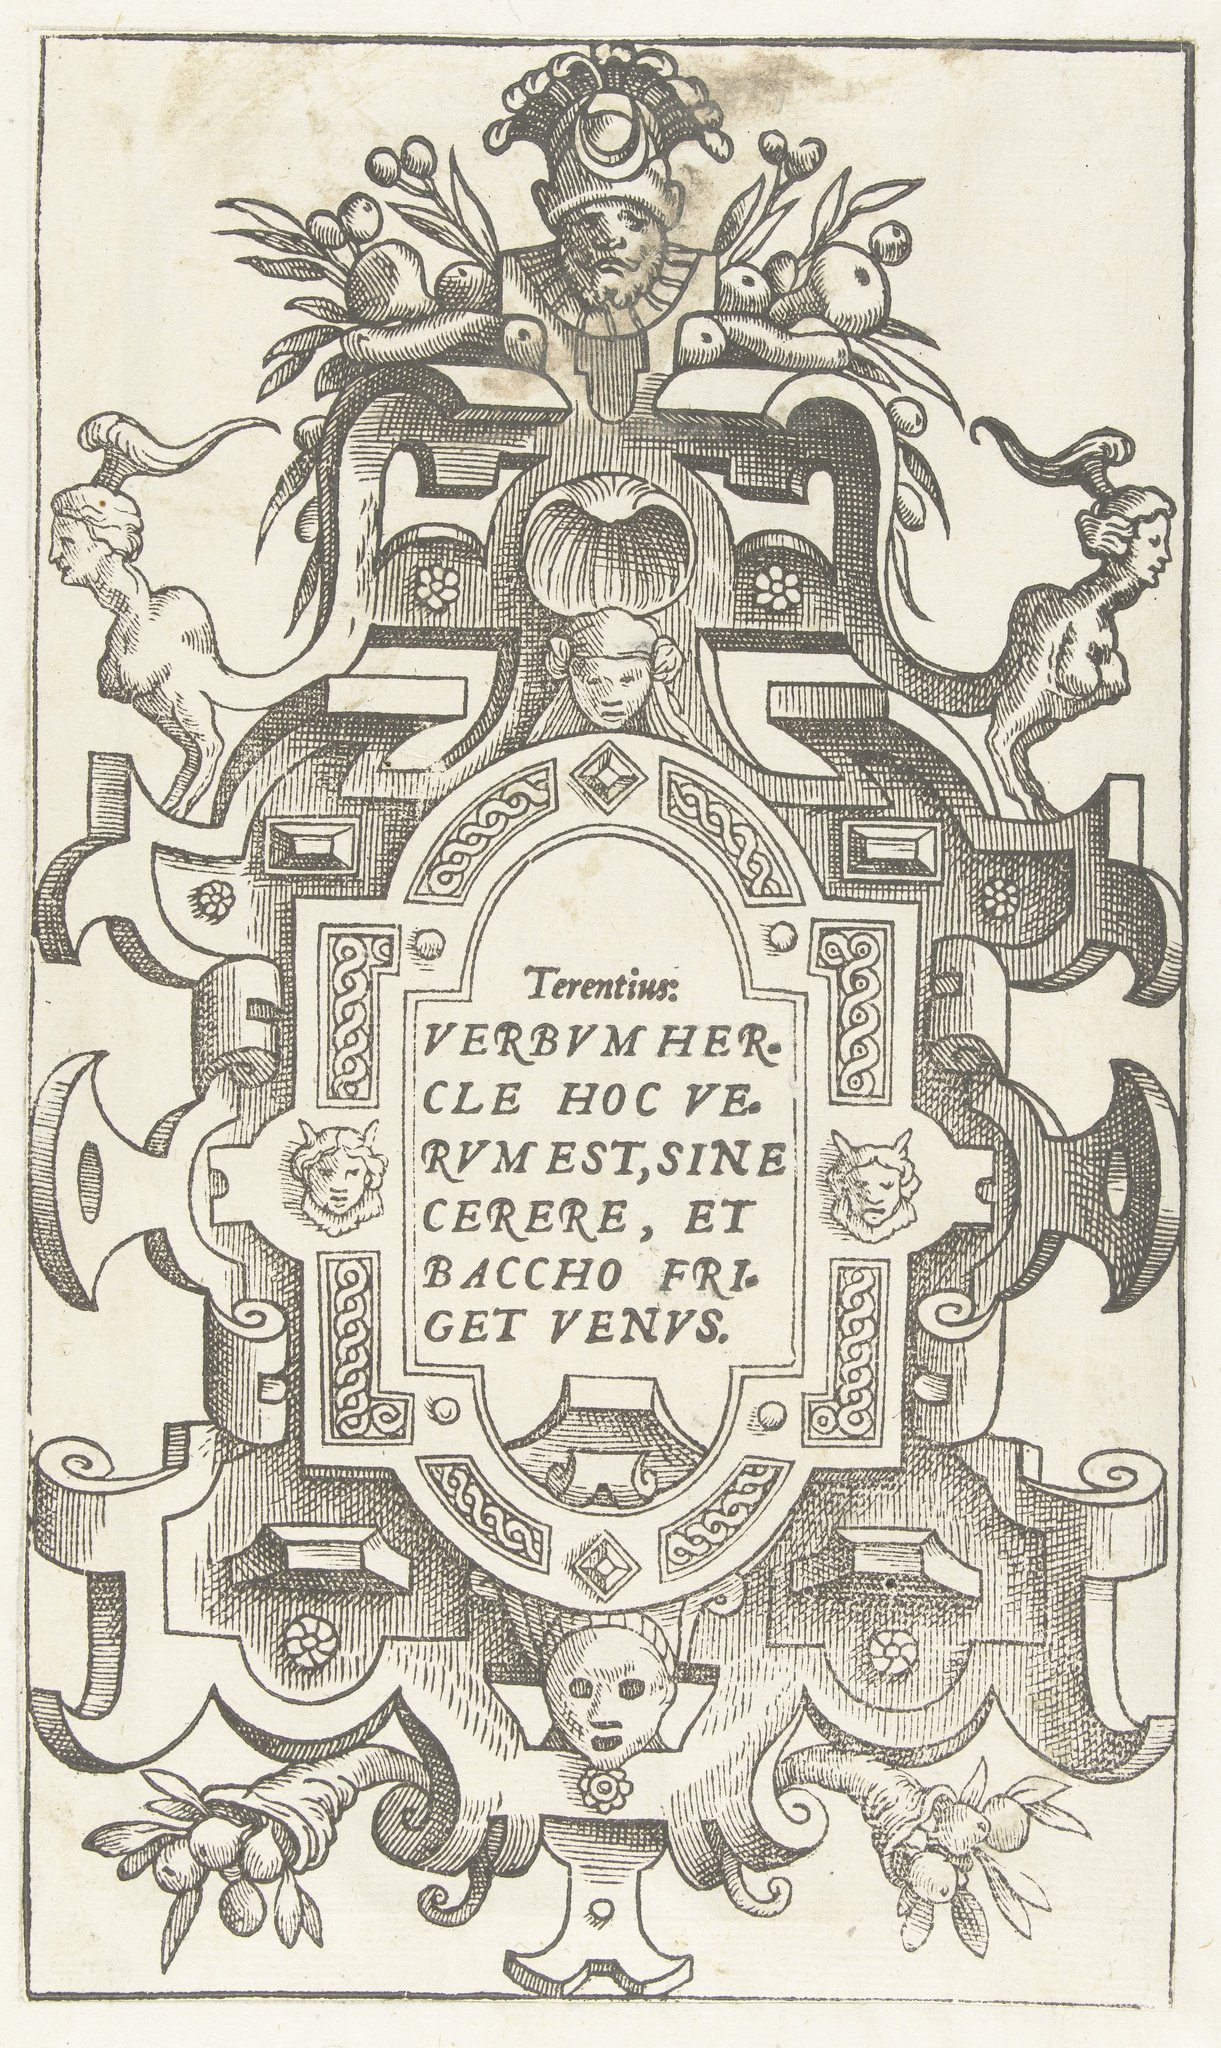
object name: ornament print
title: Cartouche met een citaat van Terentius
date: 1556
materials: paper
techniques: woodcut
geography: netherlands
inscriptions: number: ‘108’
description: De omlijsting van rolwerk wordt bekroond door het hoofd van een man, wiens hoofddeksel getooid is met veren en een halve maan. Blad hoort bij 15 bladen met titelblad afkomstig uit een serie van 24 bladen. Houtsneden.